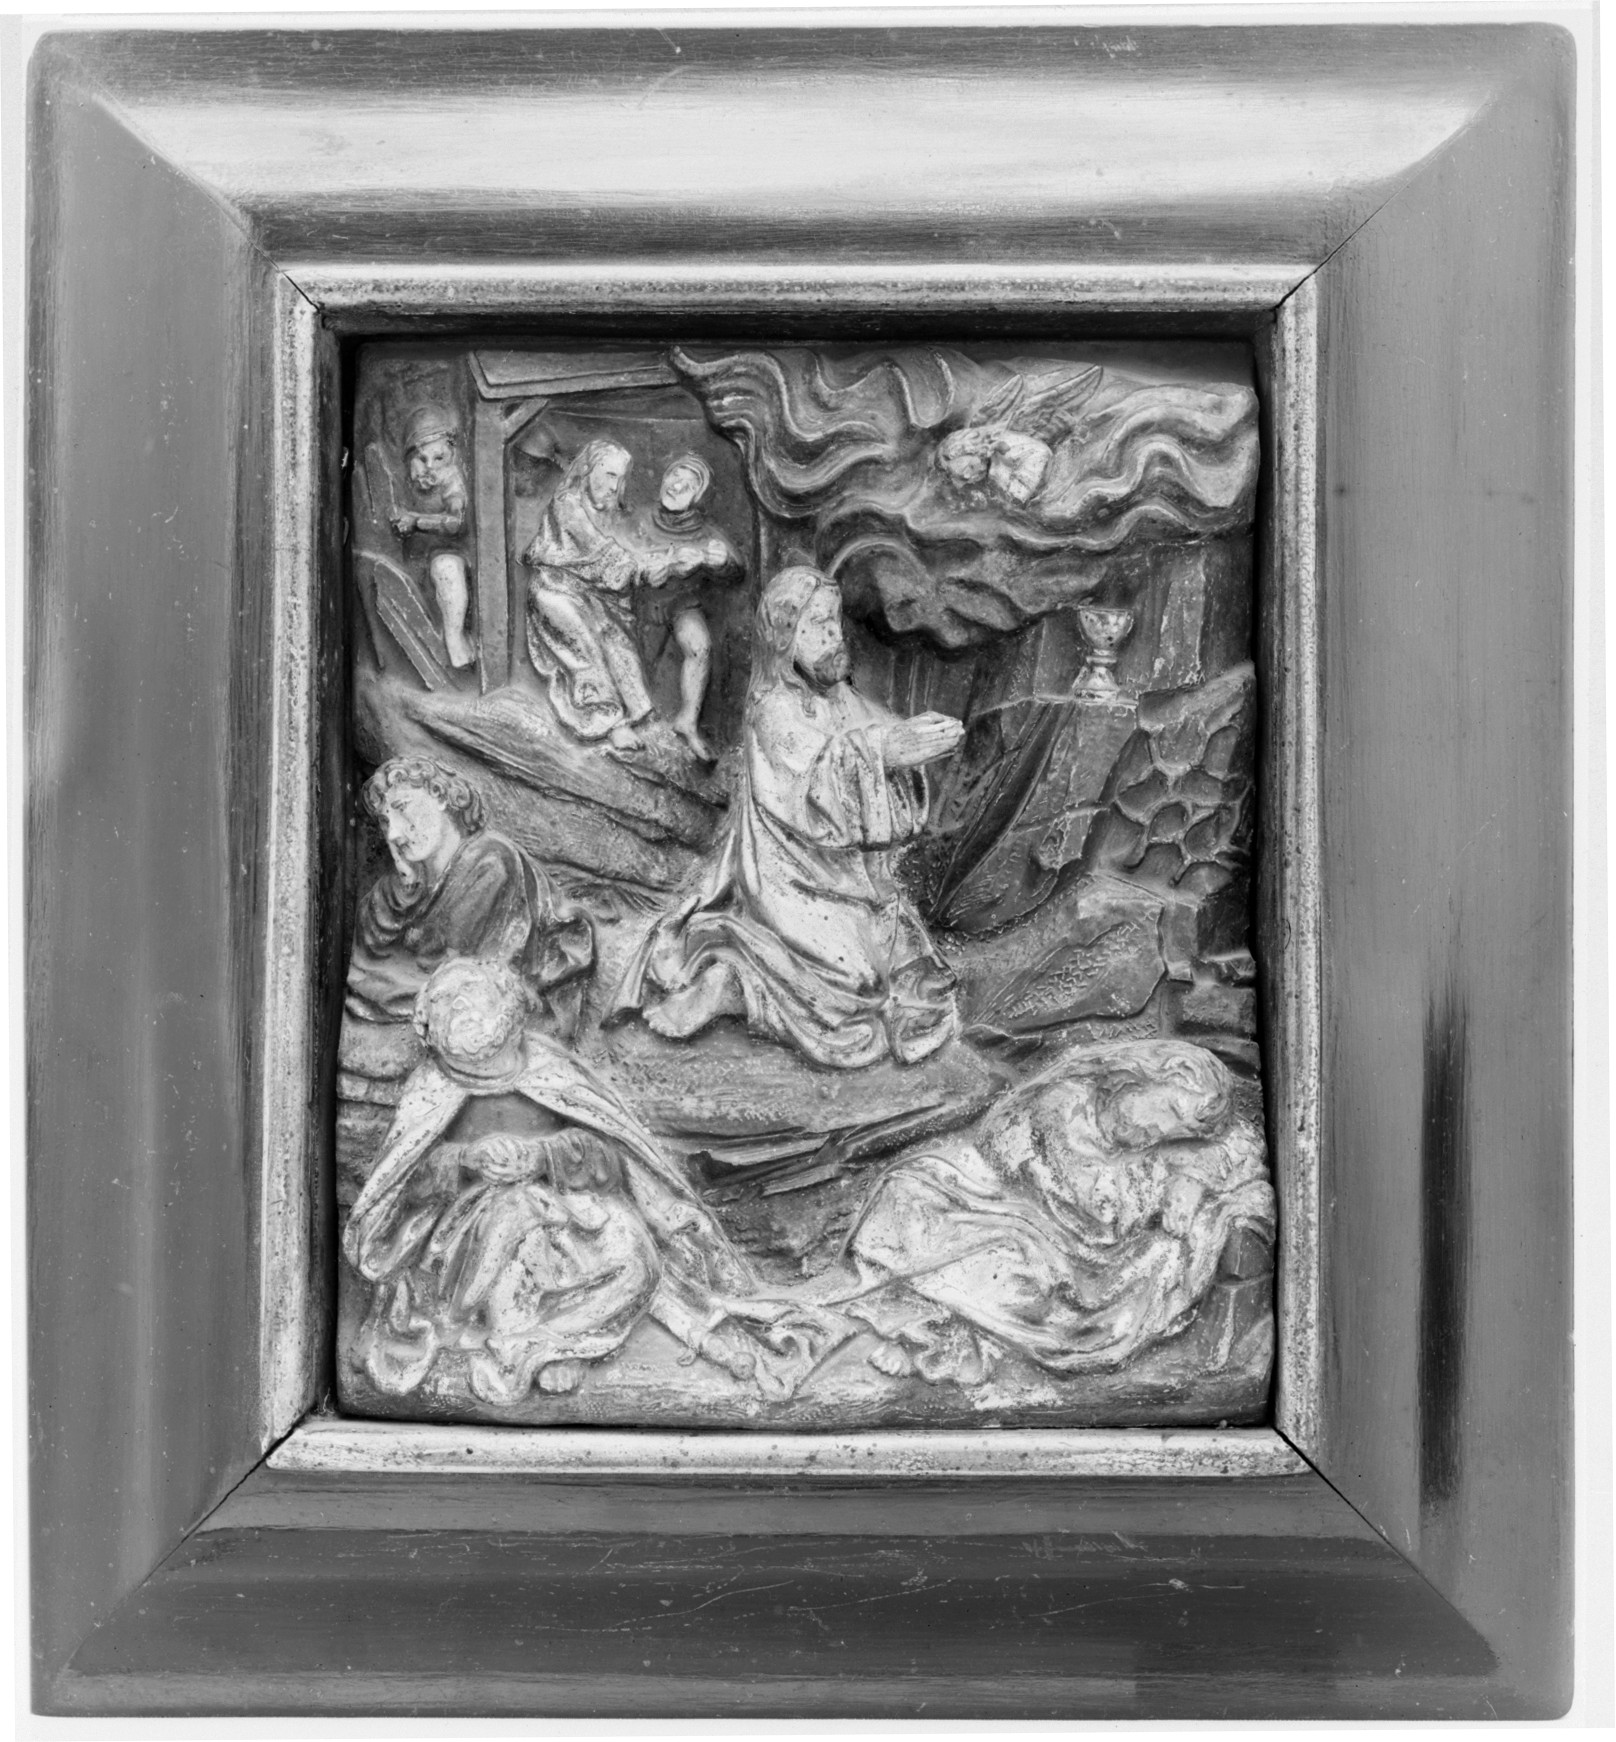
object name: relief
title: The Agony in the Garden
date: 1801-1900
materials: clay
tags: human figures